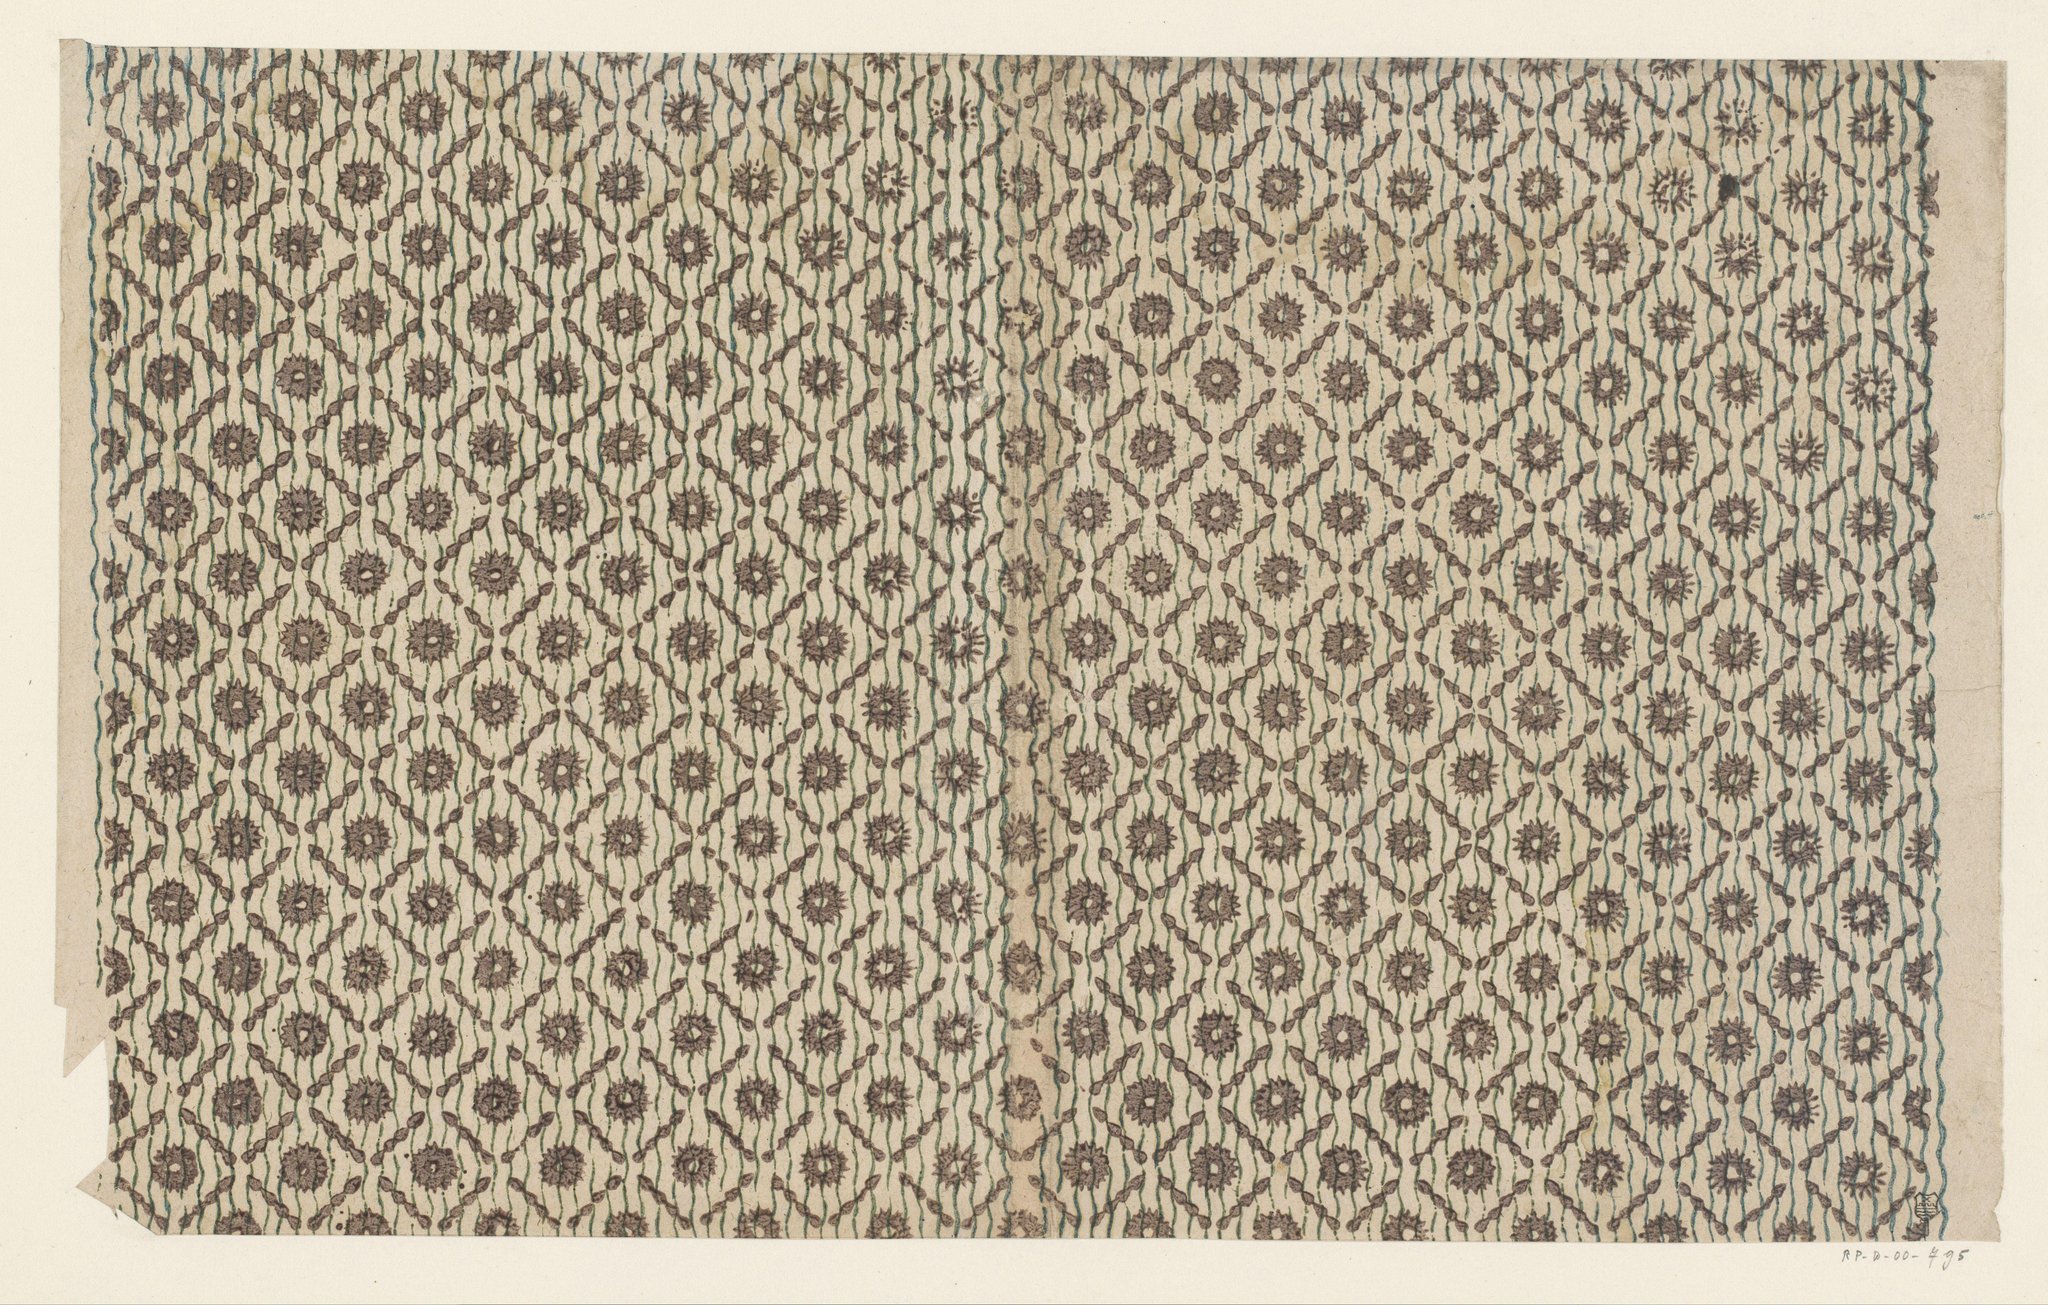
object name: wrapper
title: Blad met ruitenpatroon met bloemmotief als veldvulling onder doorlopend lijnenfond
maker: Anonymous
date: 1750-1950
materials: paper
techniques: printing block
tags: ornament derived from plant forms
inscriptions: collector's mark: Lugt 2760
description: Blad met ruitenpatroon met bloemmotief als veldvulling onder doorlopend lijnenfond. Gebruikt als omslag.